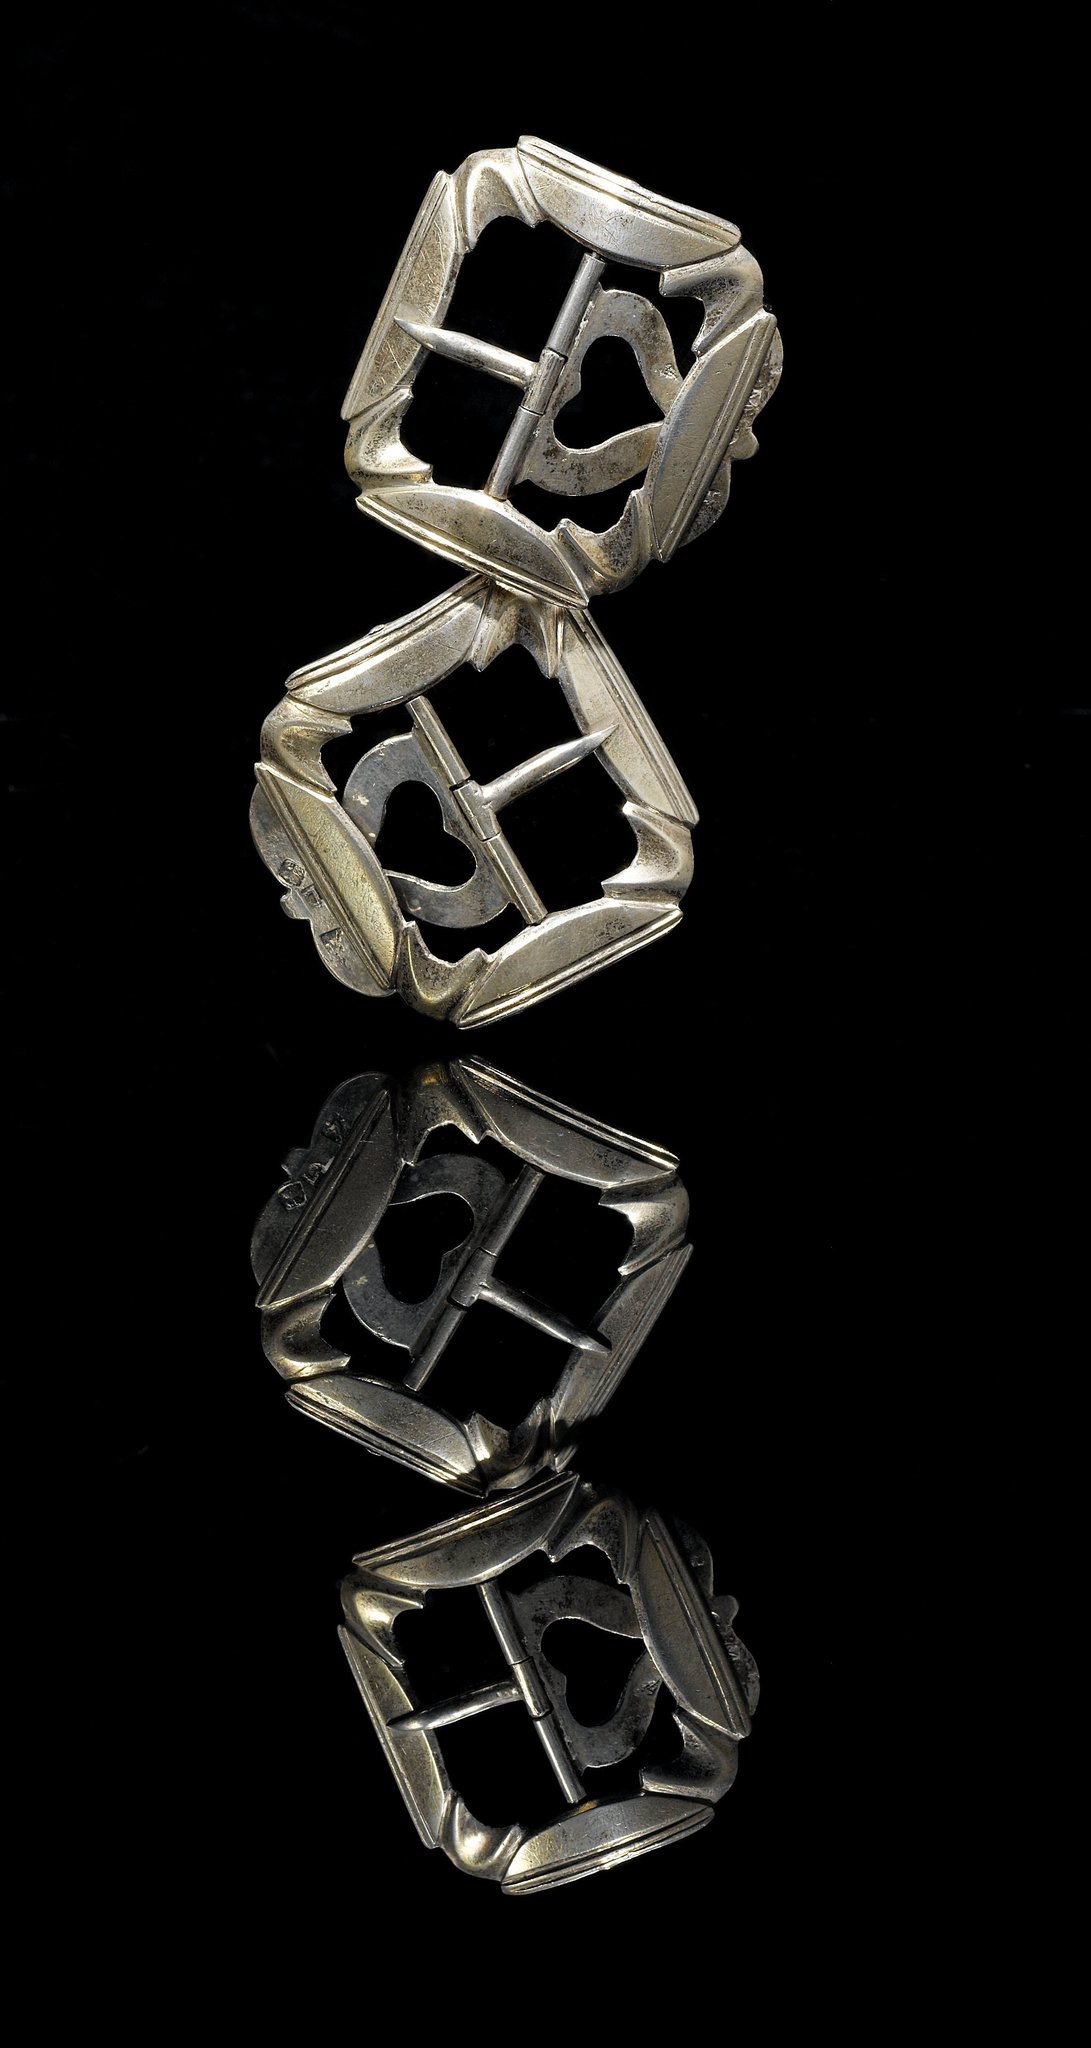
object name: jewellery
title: Een paar zilveren schoengespen, met een symmetrische versiering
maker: jan labberton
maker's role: silversmith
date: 1805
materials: silver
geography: schoonhoven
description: Een paar zilveren schoengespen, met een symmetrische versiering.